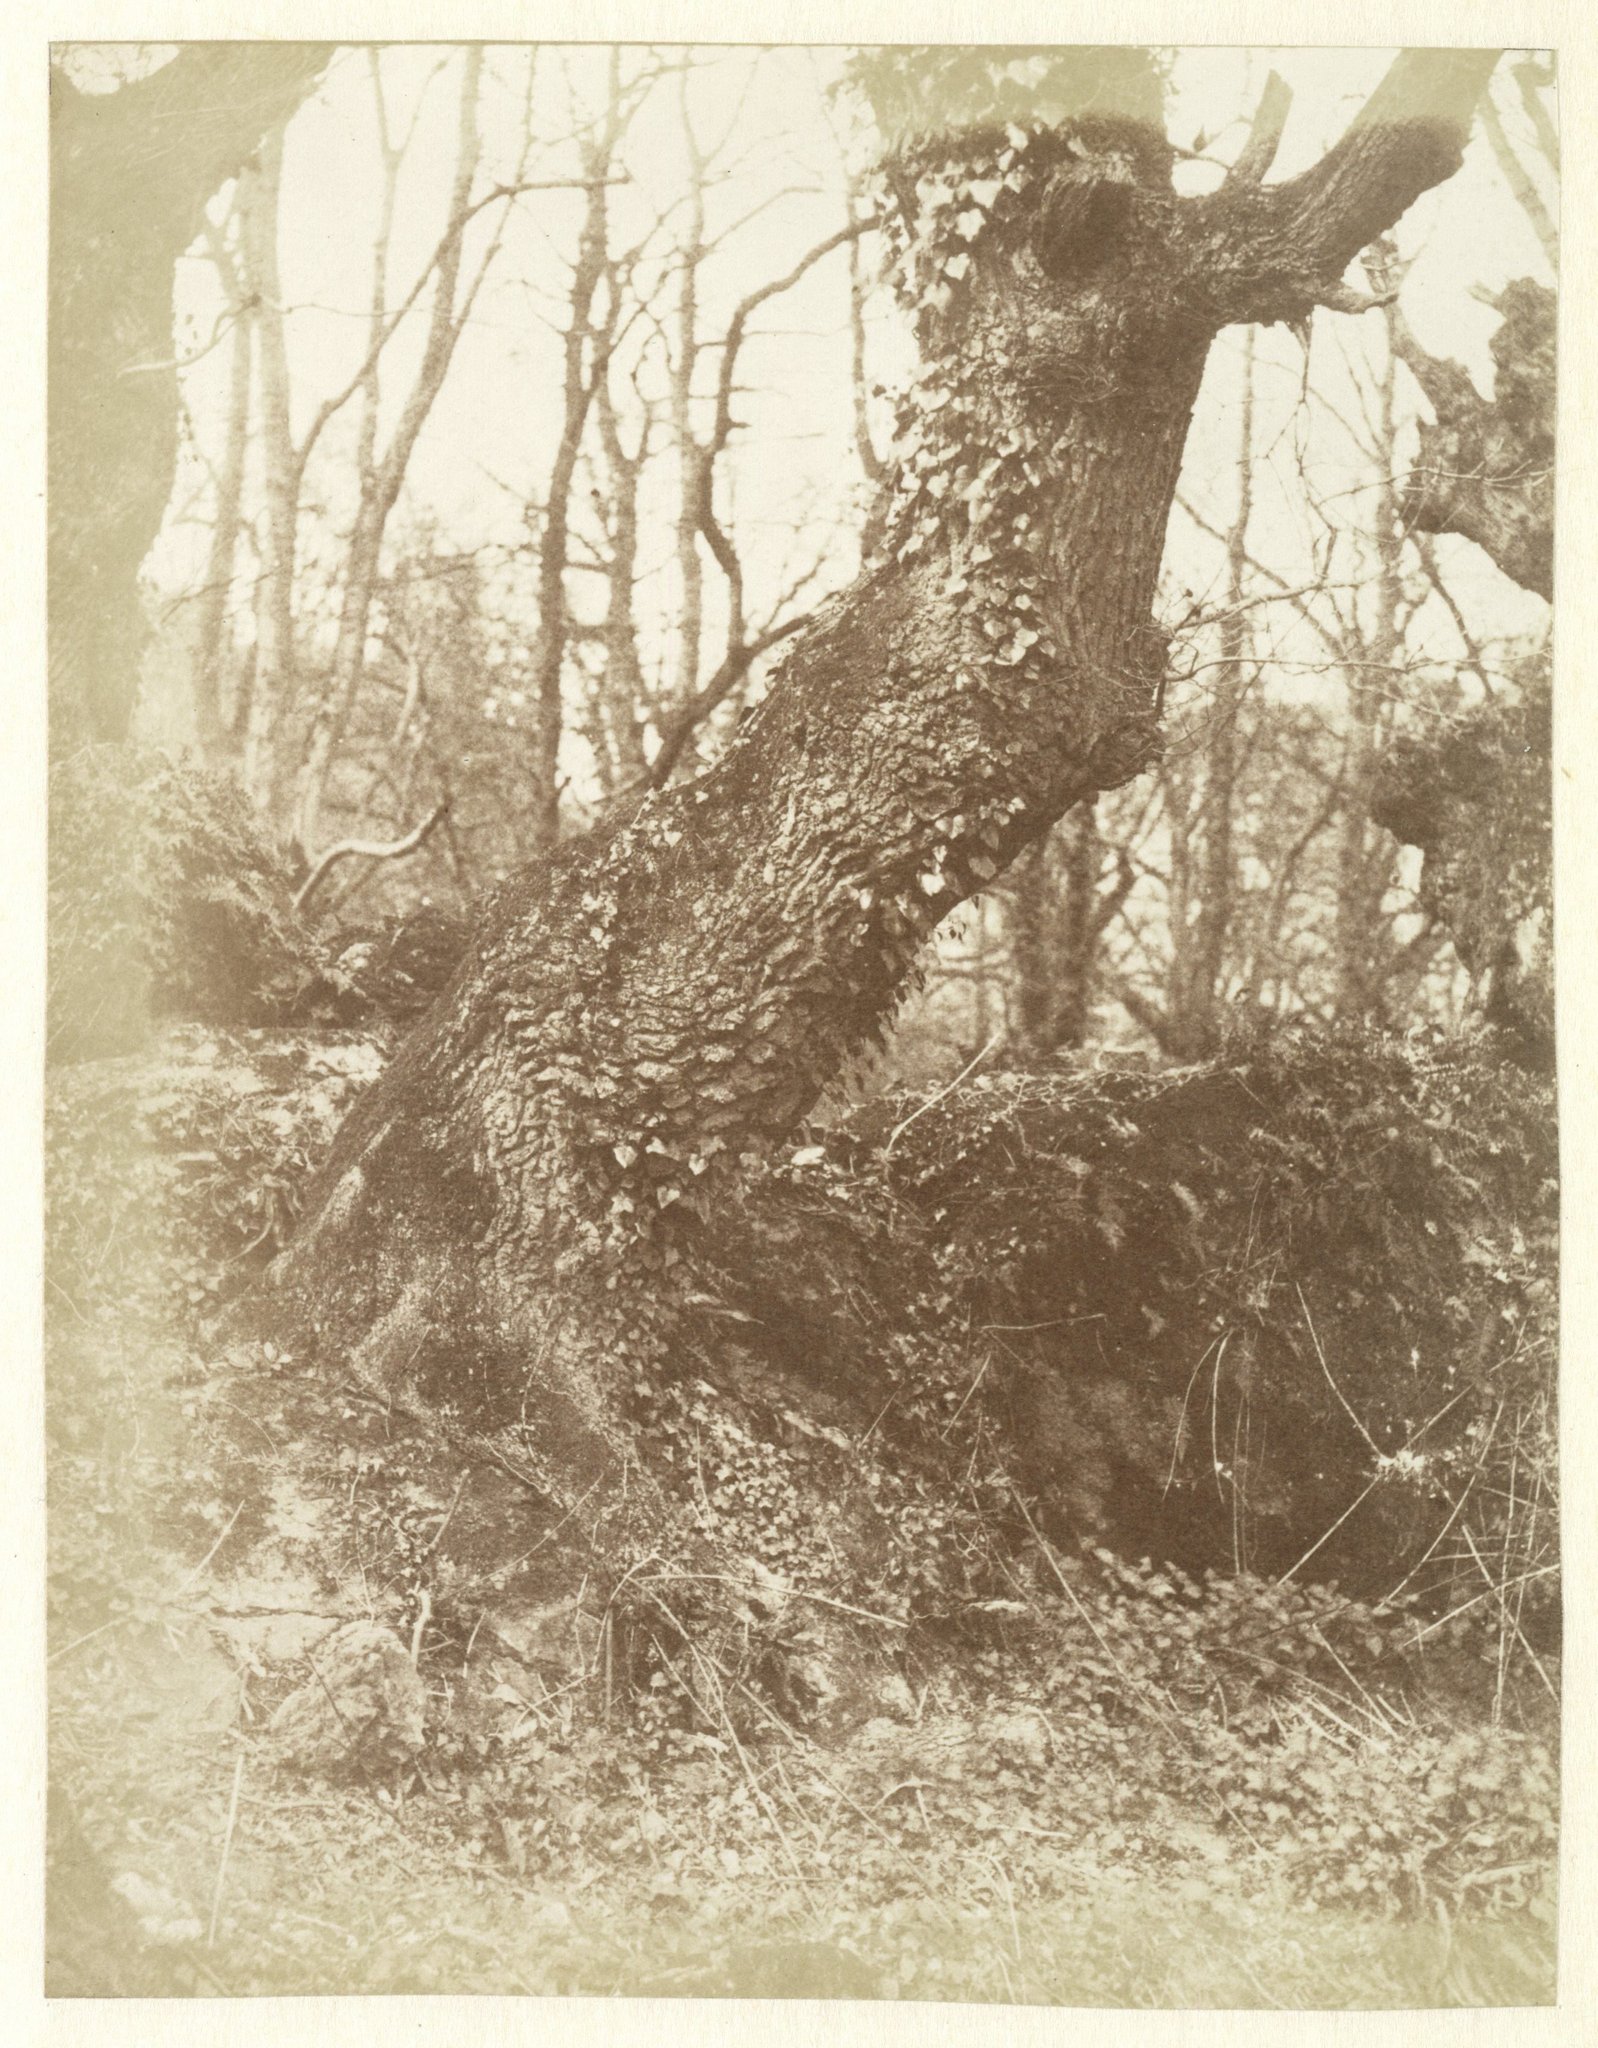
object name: photograph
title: Boomstudie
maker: hugh owen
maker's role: fotograaf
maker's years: 1808-1897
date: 1845-1856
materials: photographic support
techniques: salted paper print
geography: great britain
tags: trees, great britain